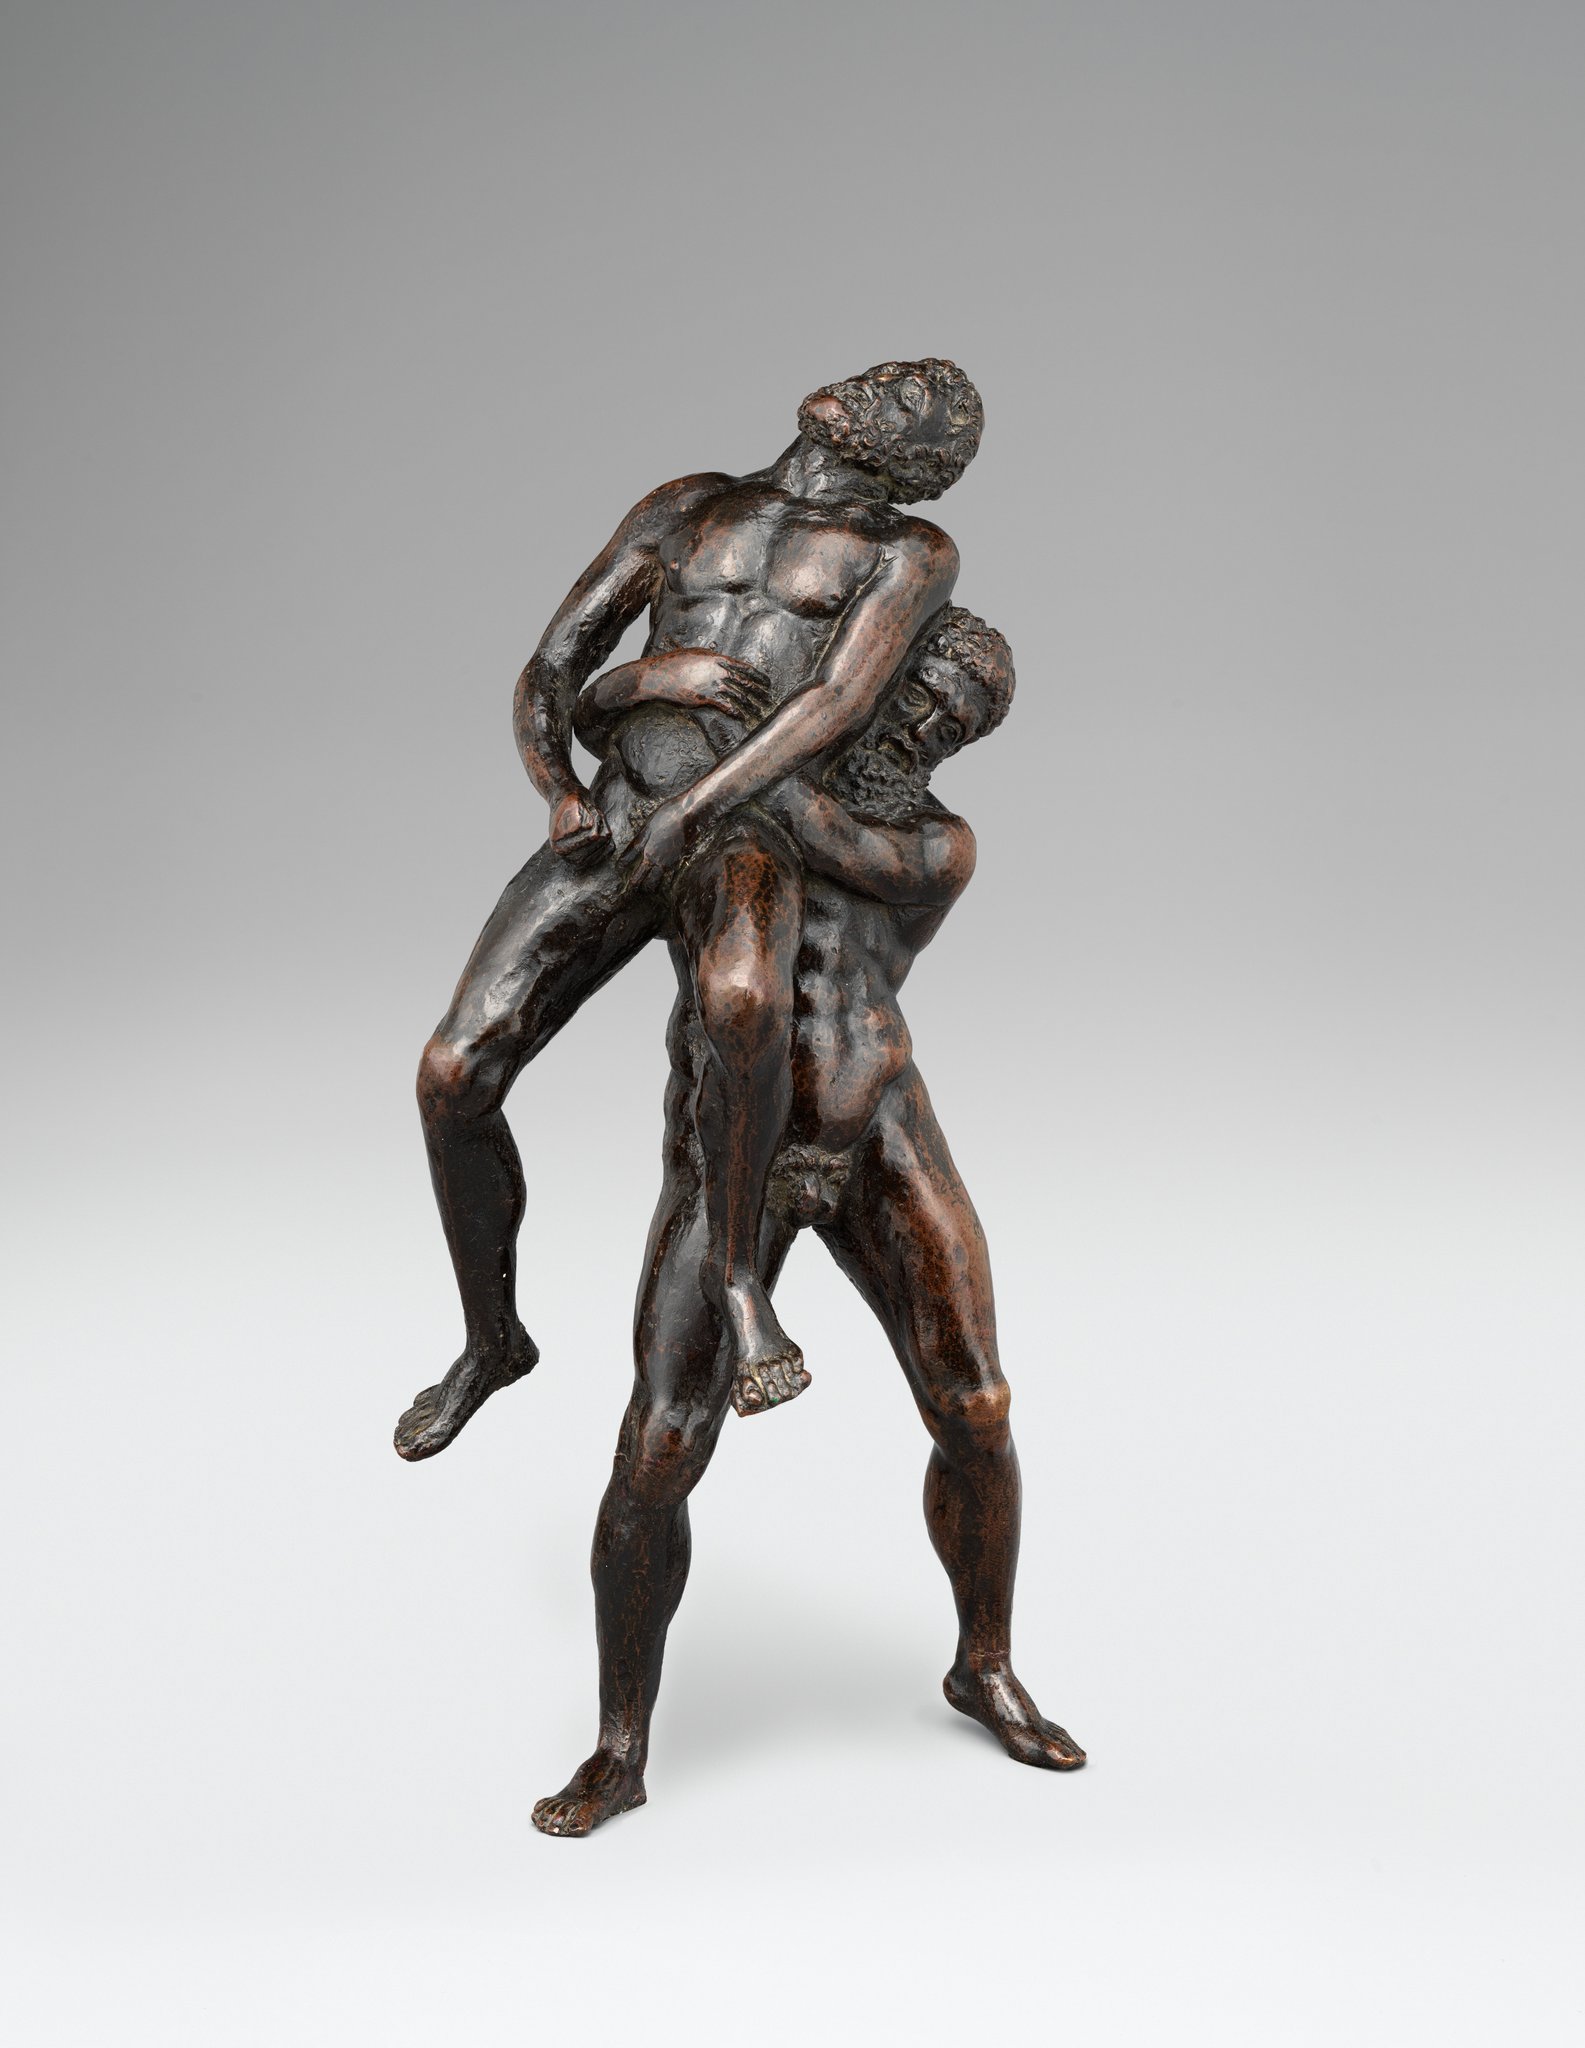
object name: statuette group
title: Hercules and Antaeus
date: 1801-1900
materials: bronze, lacquer, patina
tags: male nudes,hercules,antaeus